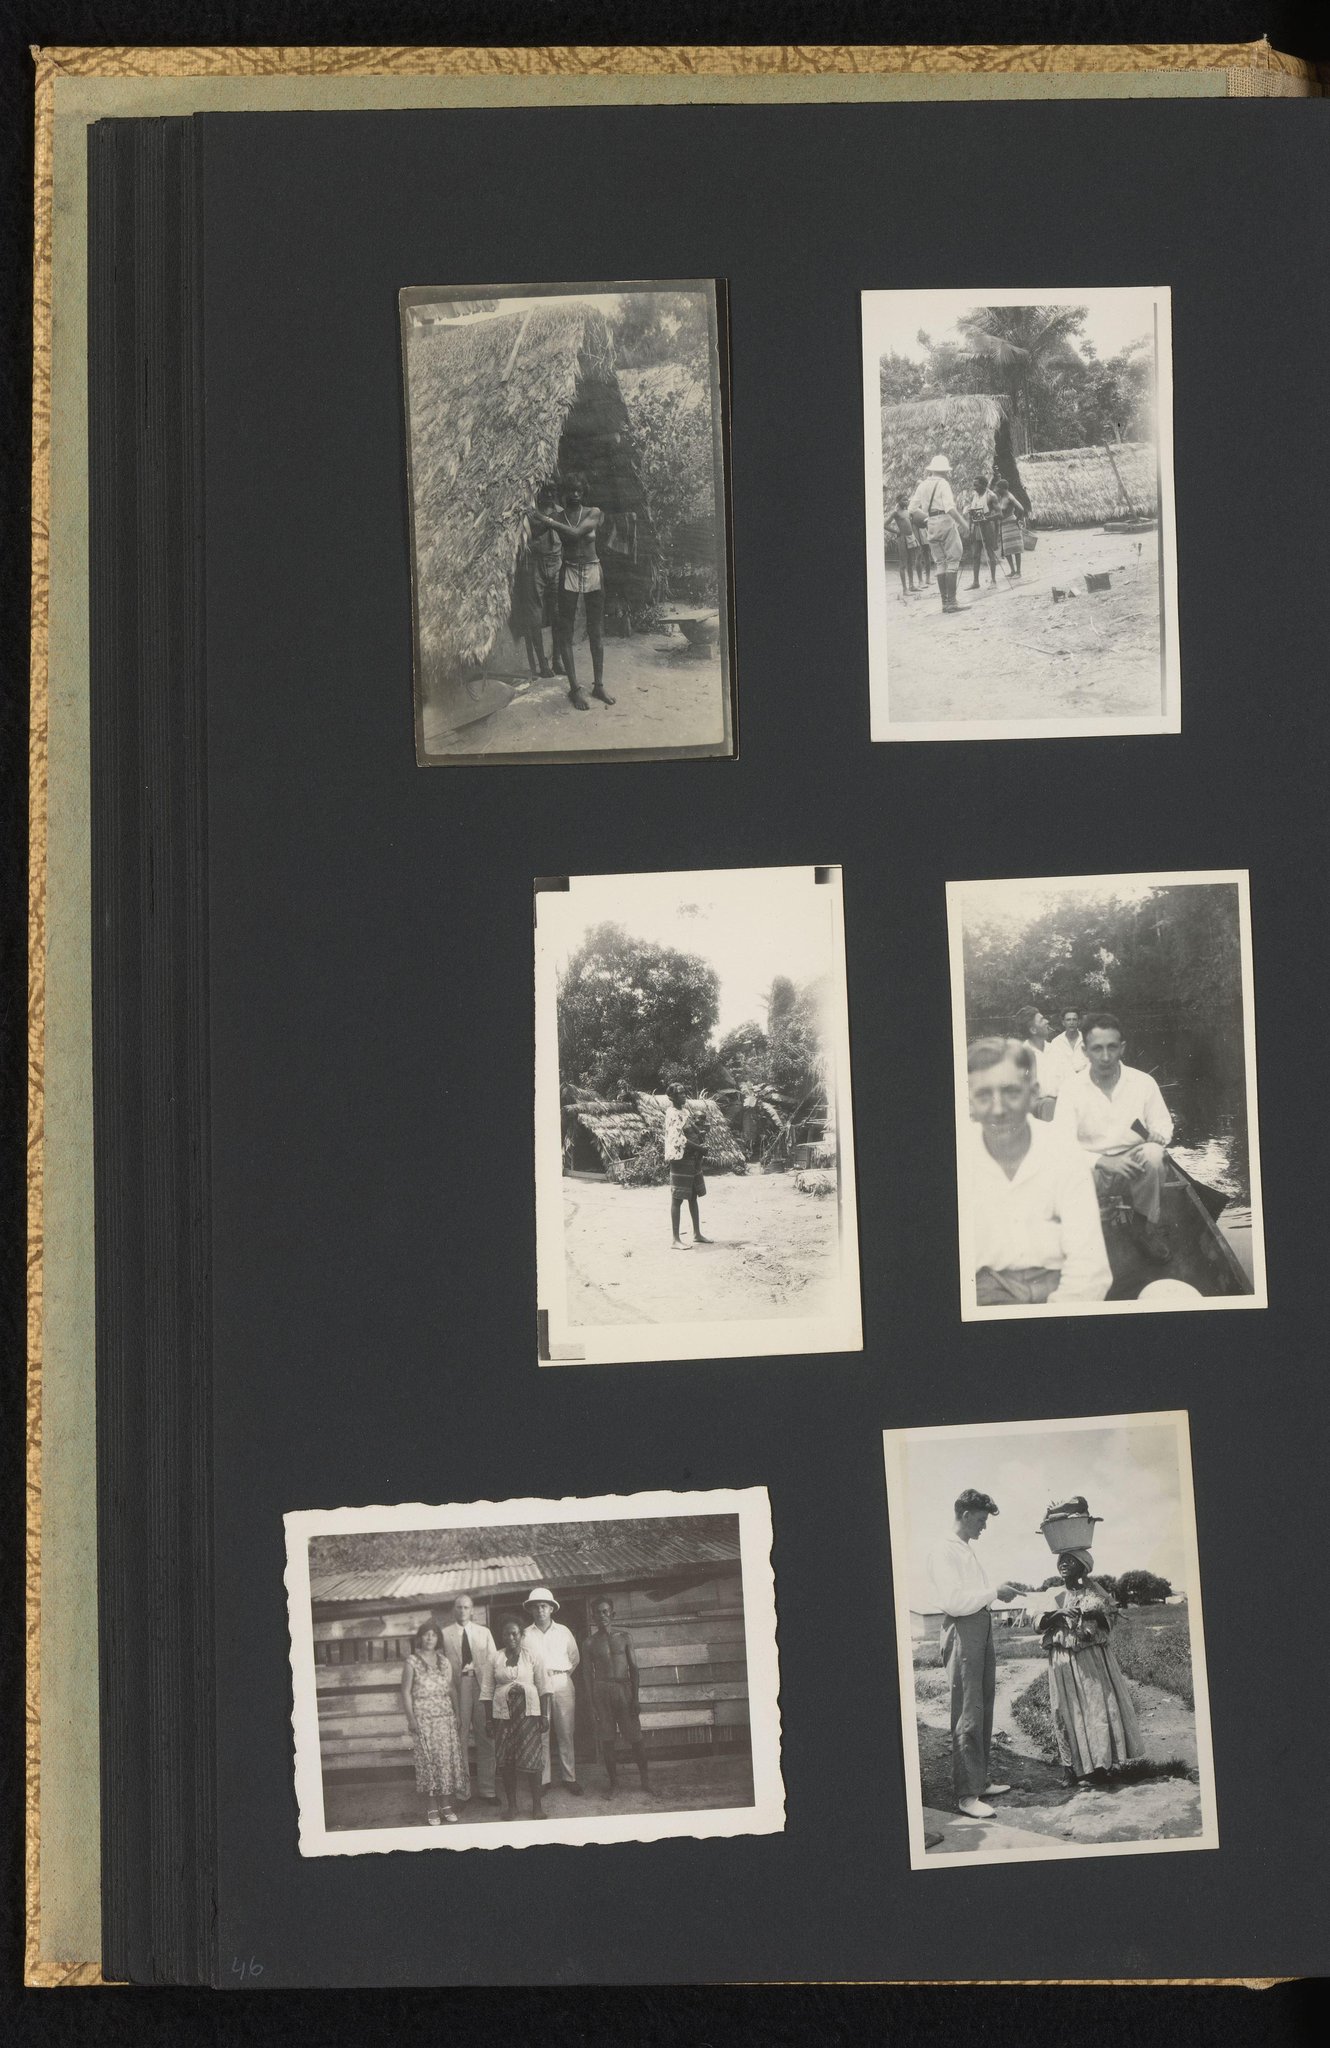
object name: album leaf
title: Bezoek aan een dorp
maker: Anonymous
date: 1927-1931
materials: paper, photographic support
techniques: gelatin silver print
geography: suriname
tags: village, suriname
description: Albumblad met zes foto's van een bezoek gebracht door een groep Europeanen aan een Surinaams dorp. Onderdeel van het album van de familie Guilonard over de bauxietwinning in Moengo en Albina in Suriname in de jaren 1929-1930.